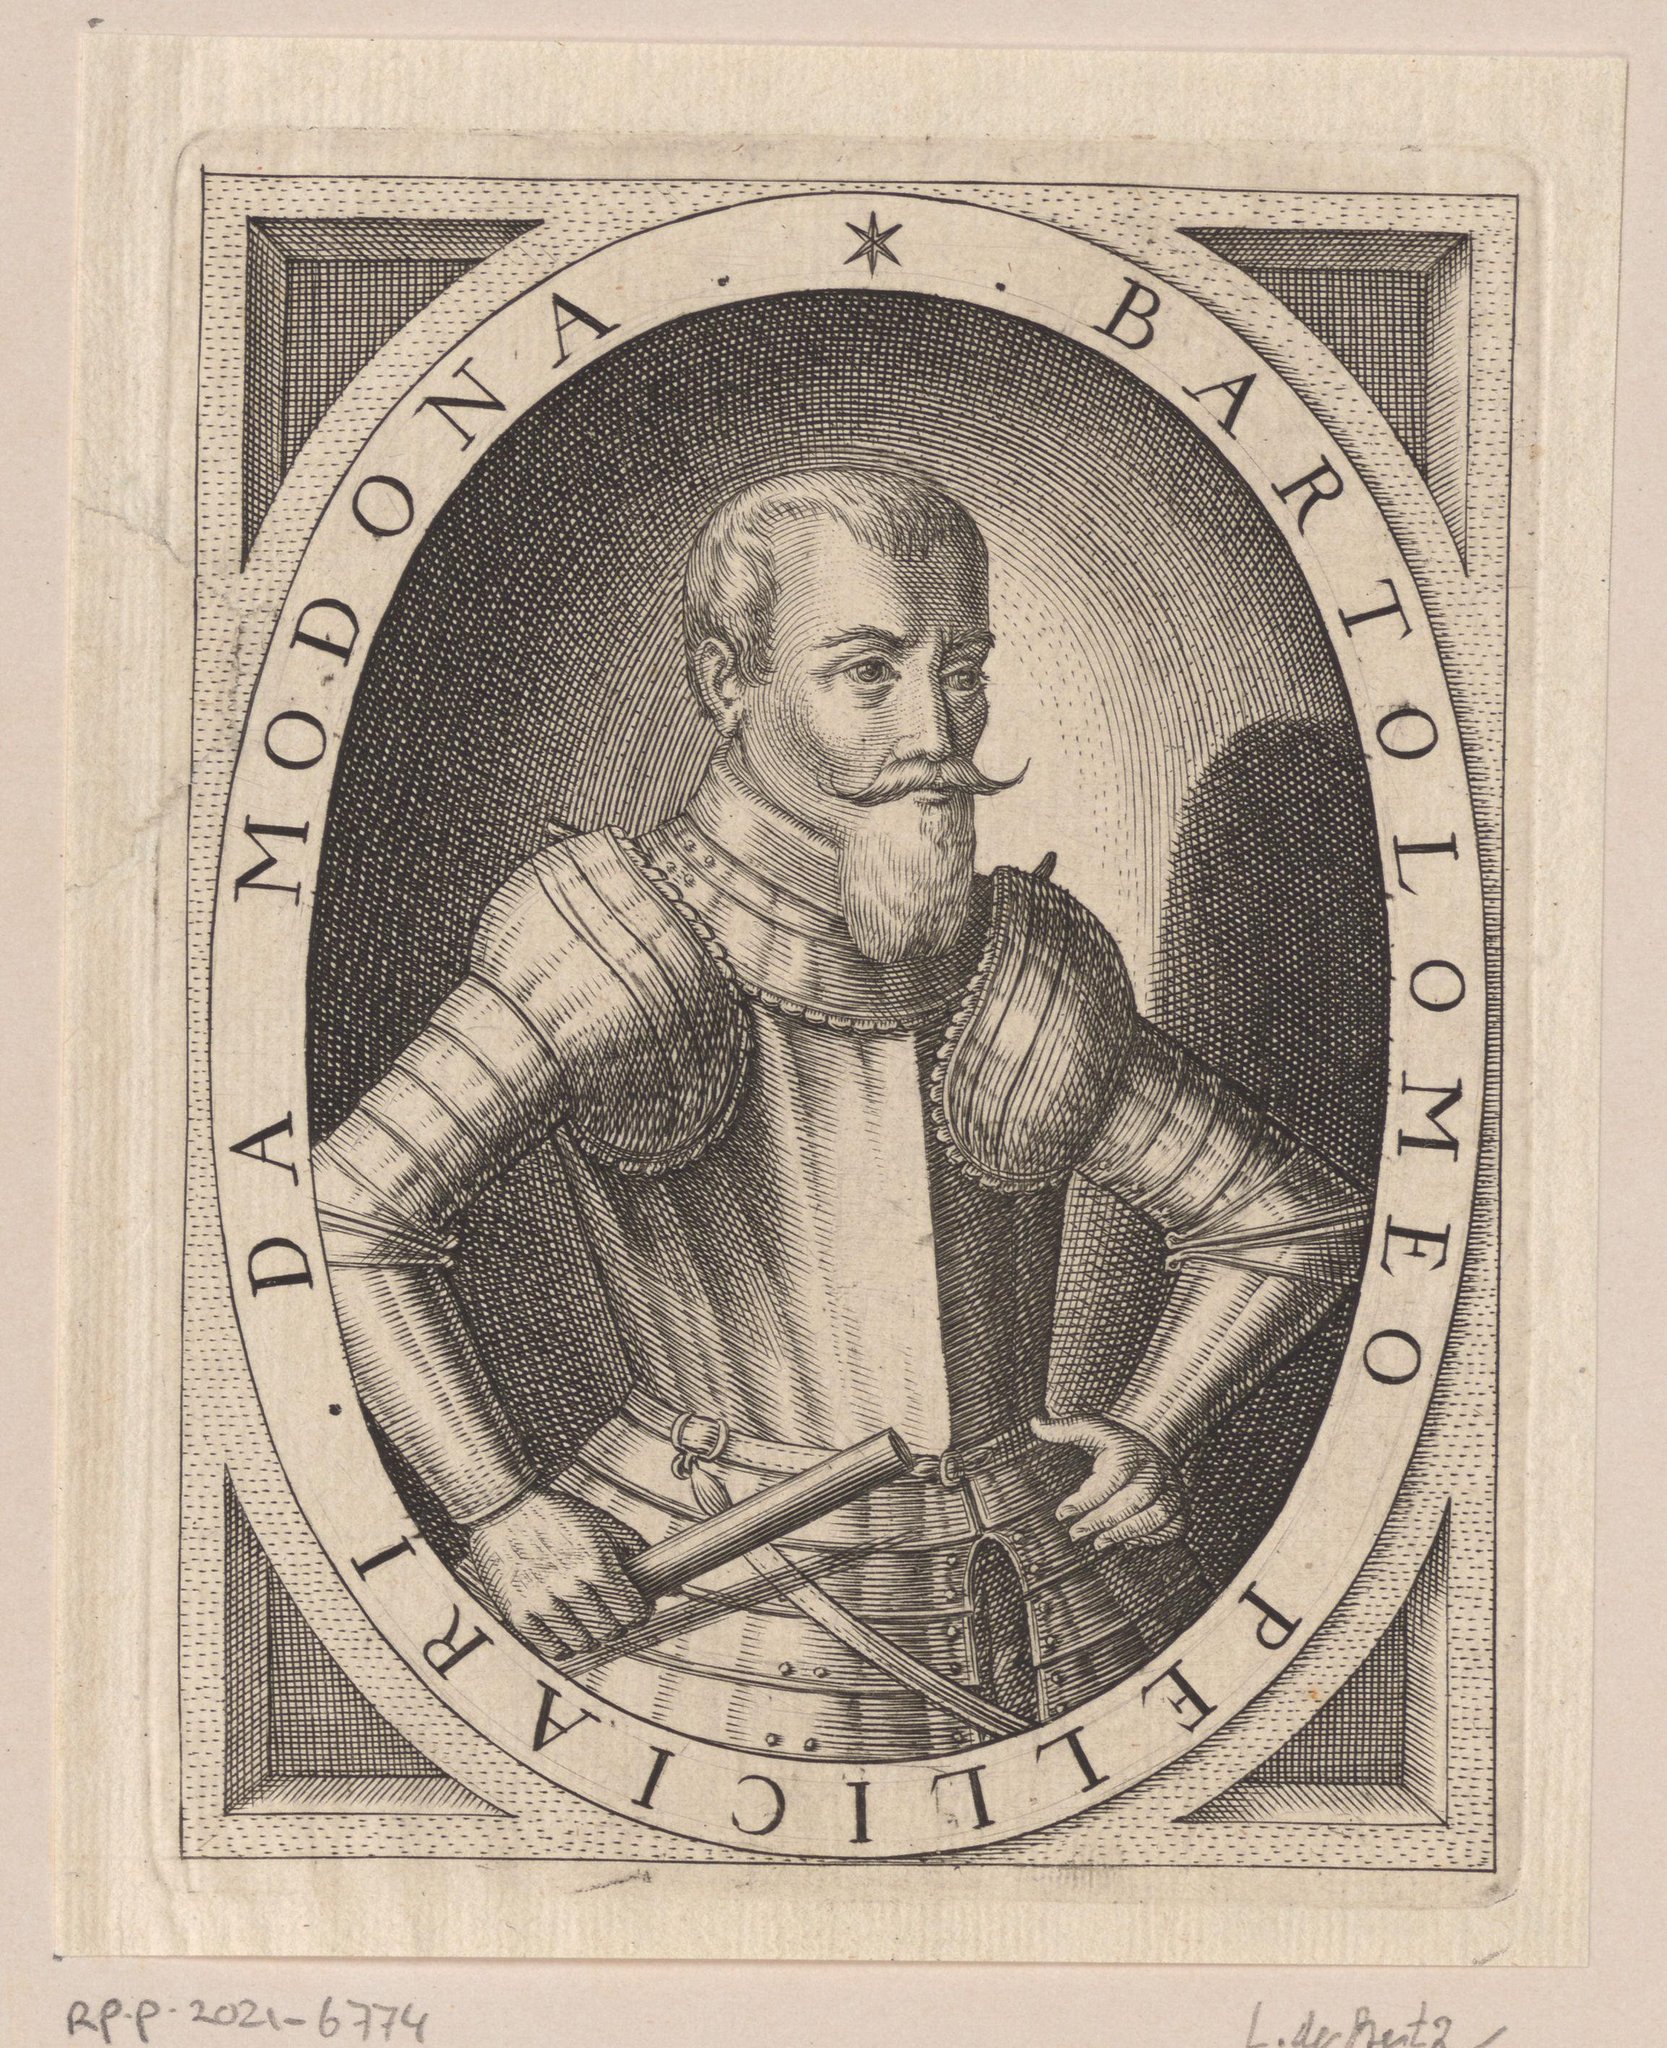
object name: print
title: Portret van Bartolomeo Pelliciari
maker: Anonymous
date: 1625-1749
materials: paper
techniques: engraving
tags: adult man, historical persons, (military) uniforms